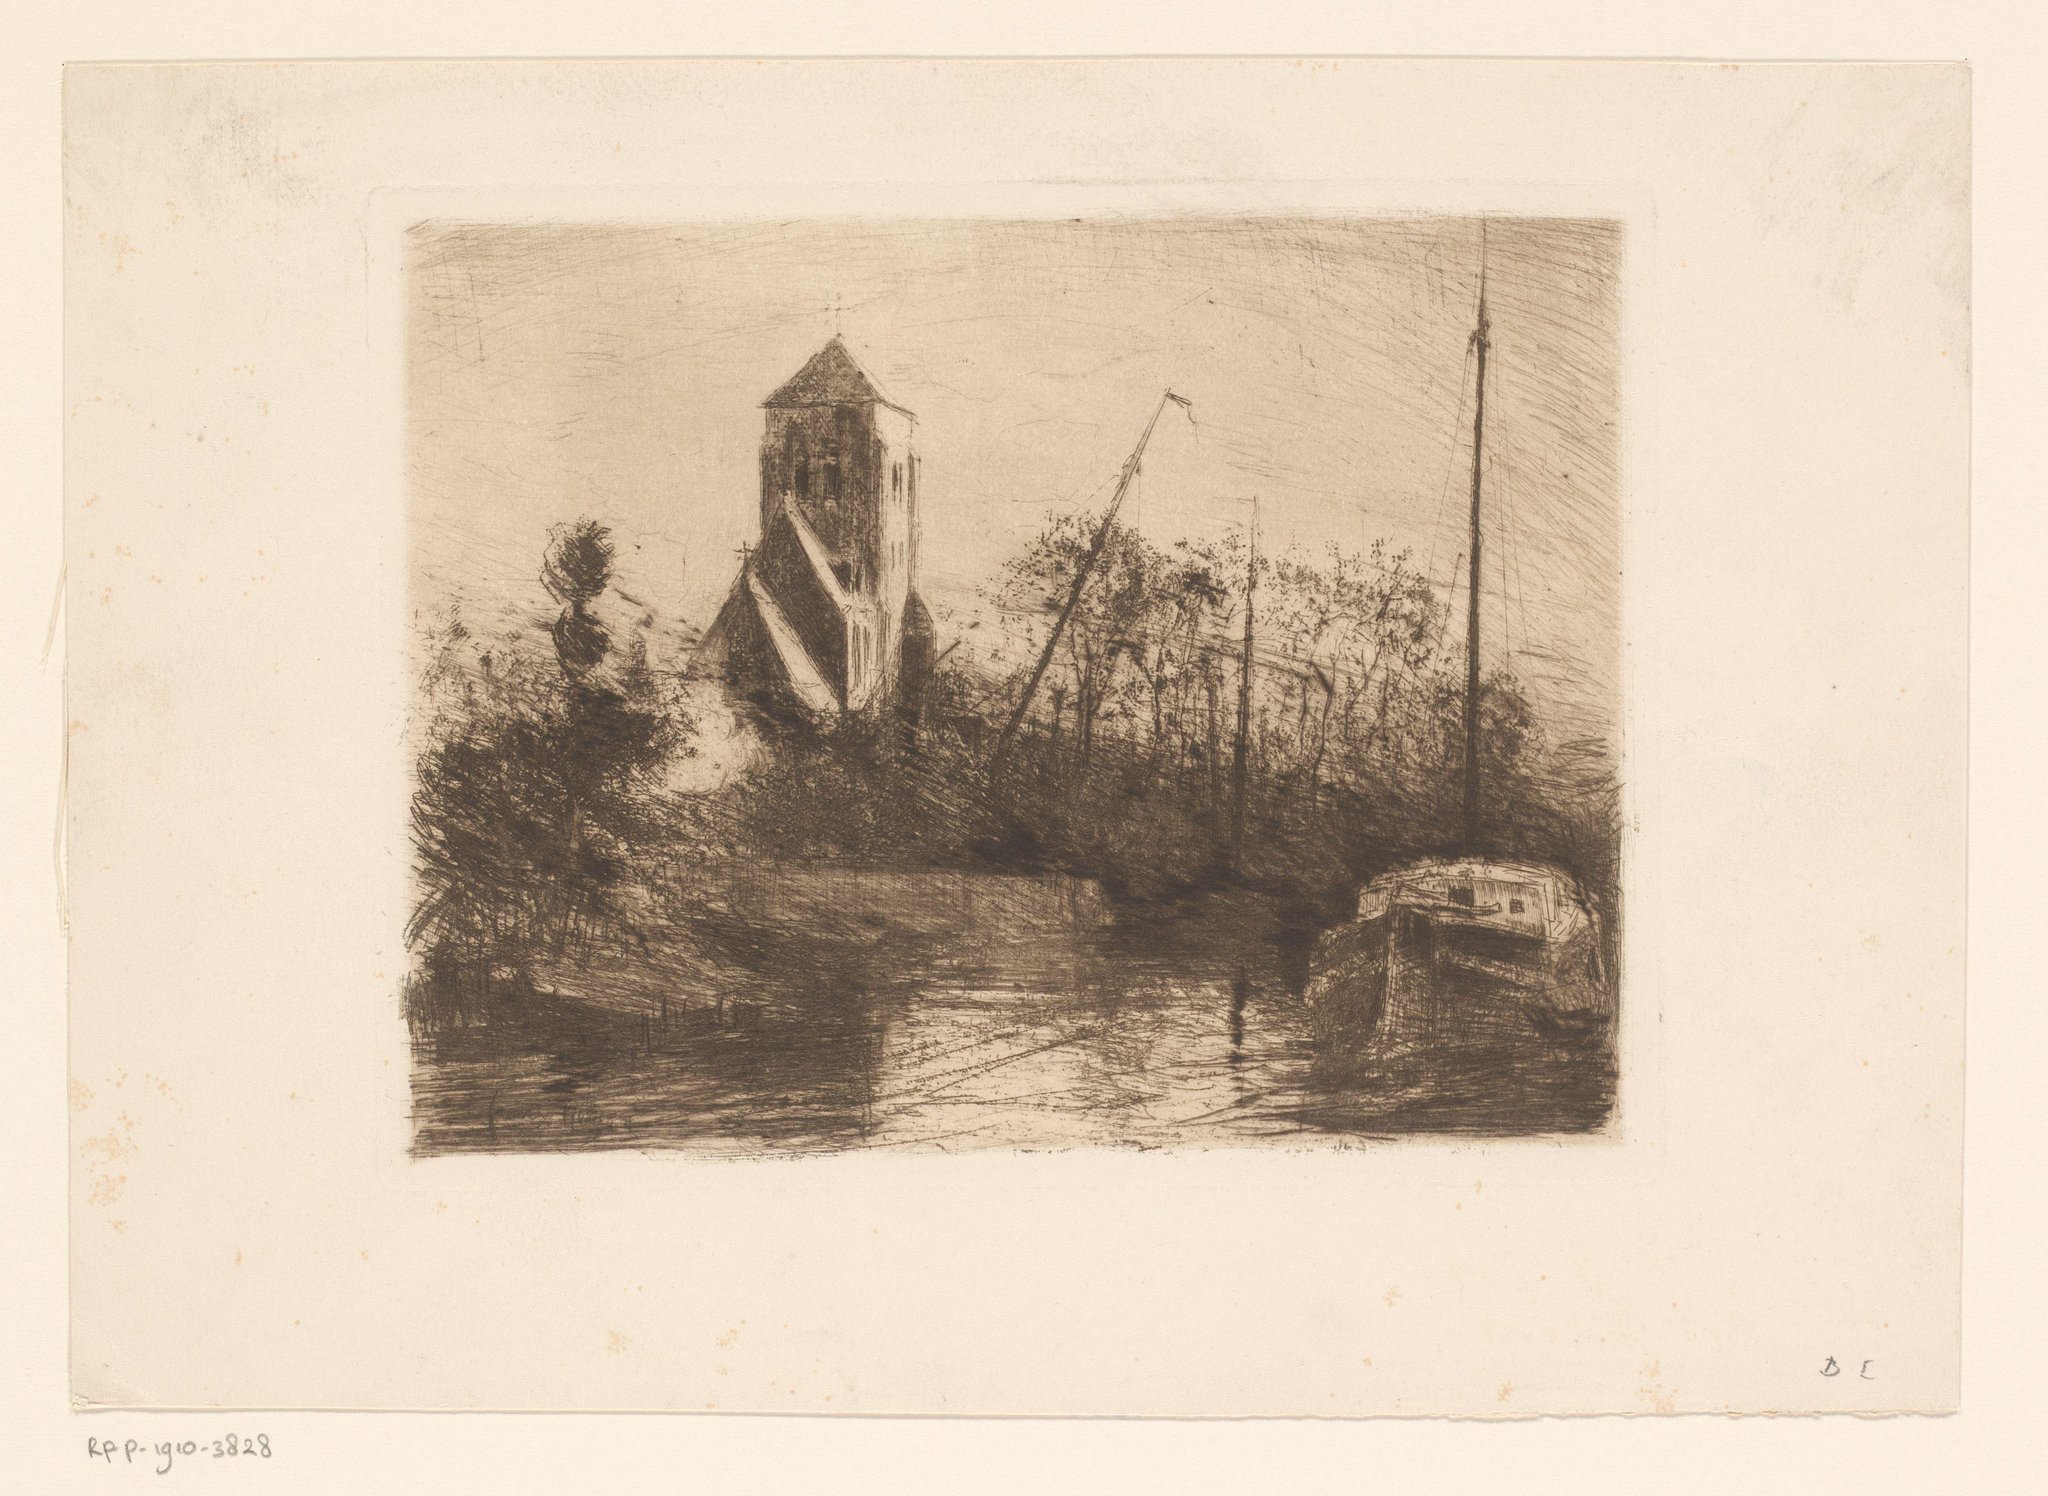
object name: print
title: Schepen in het water langs een oever met daarop een kerk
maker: frans hens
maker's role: print maker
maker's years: 1856-1928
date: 1866-1910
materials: paper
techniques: drypoint, etching, intaglio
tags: sailing-ship, sailing-boat, church (exterior), ship bound for the harbour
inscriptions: collector's mark: Lugt 2228